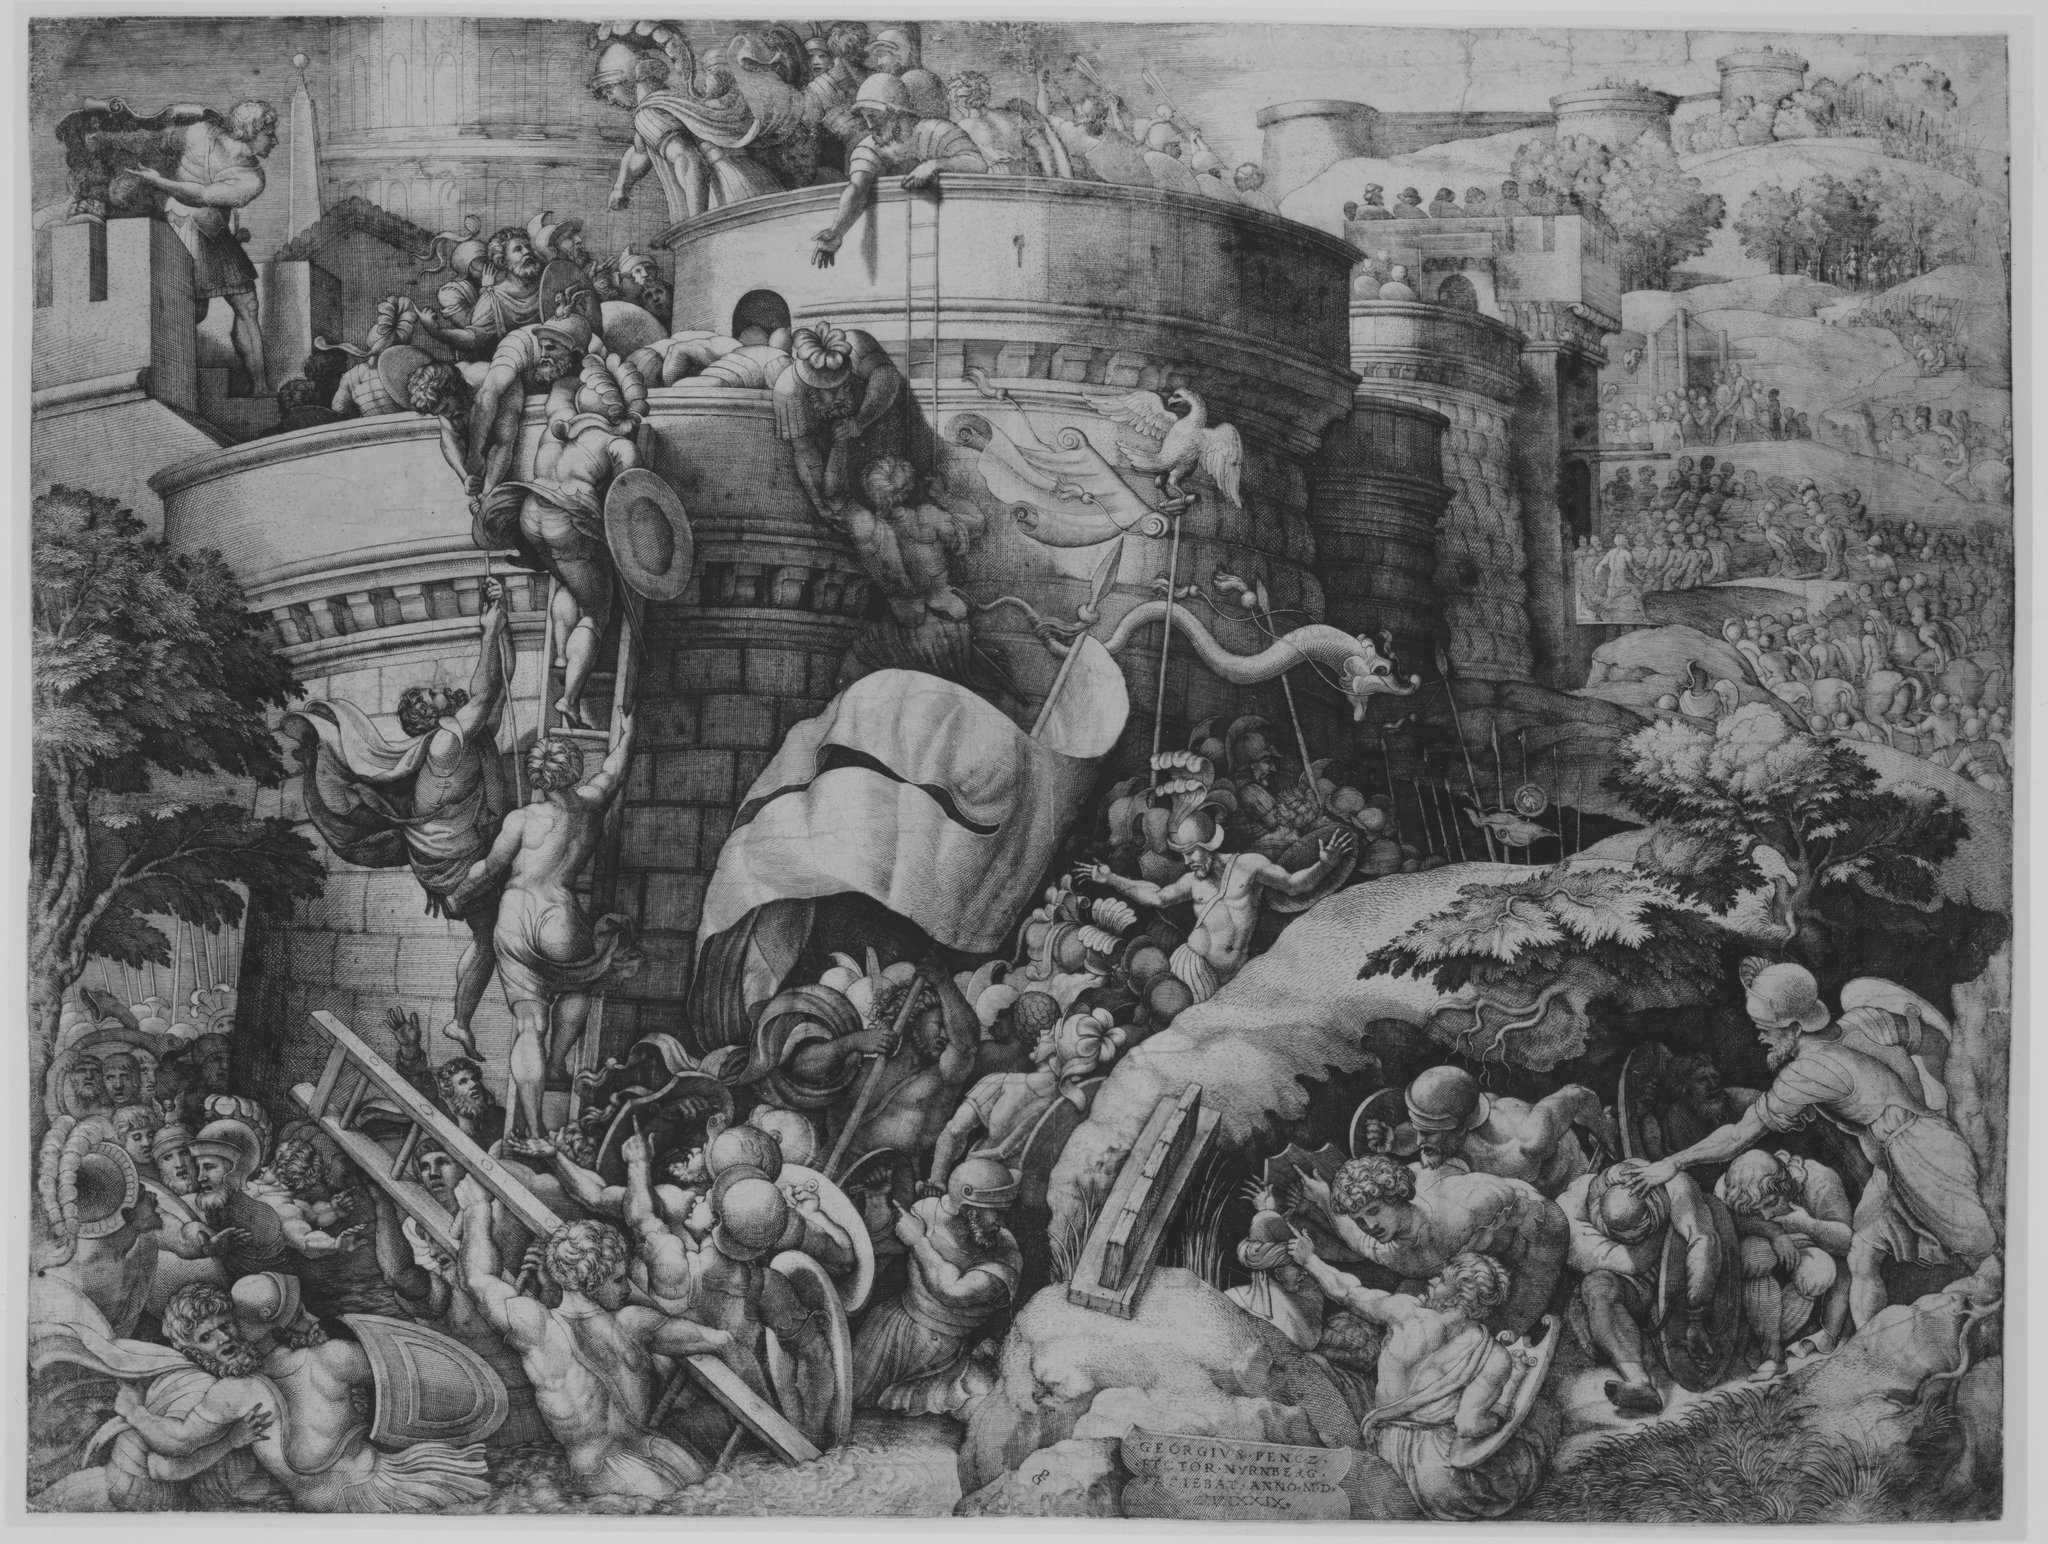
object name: print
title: The Capture of Carthagena by Scipio and His Troops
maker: georg pencz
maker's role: artist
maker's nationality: german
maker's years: 1500-1550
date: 1539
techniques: engraving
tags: soldiers,shields,men,crowd,ladders